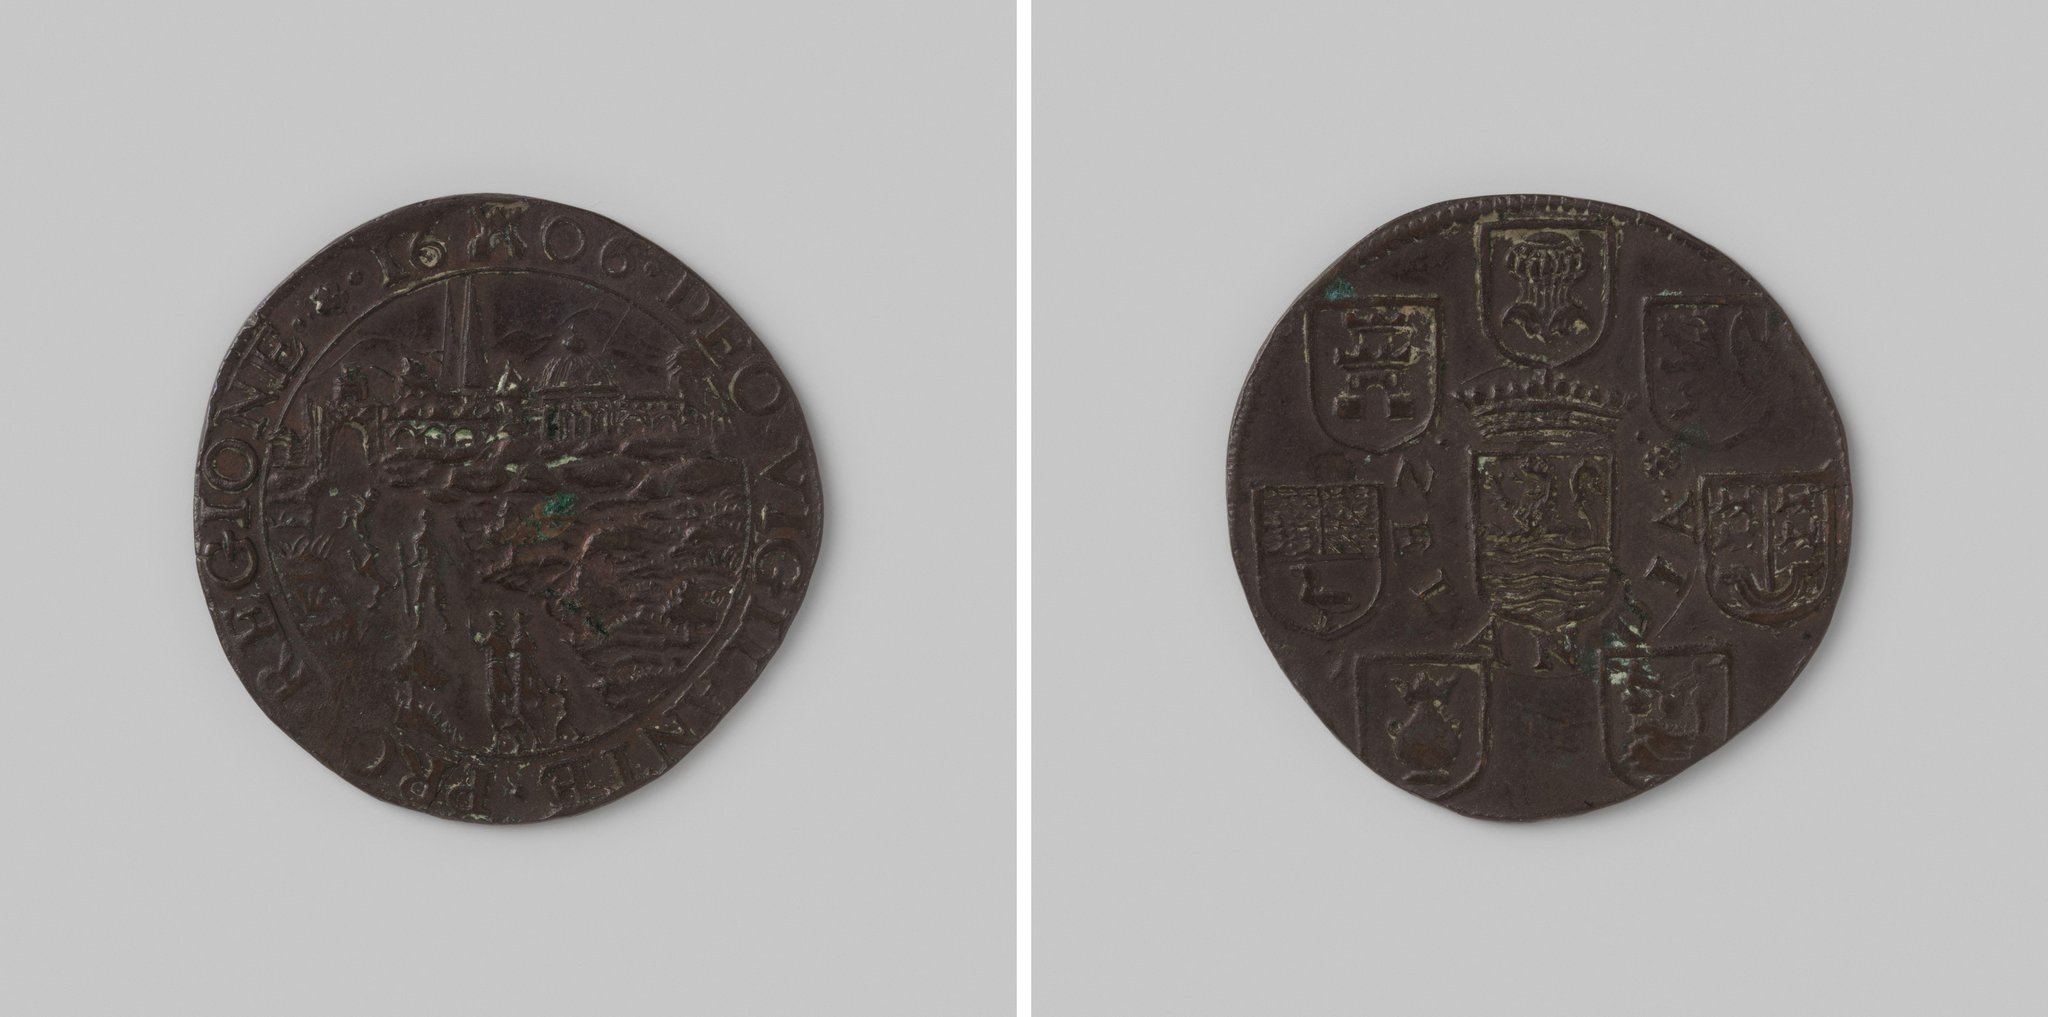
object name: history medal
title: Rekenpenning uit Middelburgt ter bemoediging van de schroomvalligheid van de ingezetenen 1606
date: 1606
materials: copper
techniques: striking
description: Koperen penning, op de voorzijde het gezicht op een stad, met omschrift, op de keerzijde het gekroonde wapenschild van Zeeland, met omschrift, waaromheen zeven stadswapenschilden.